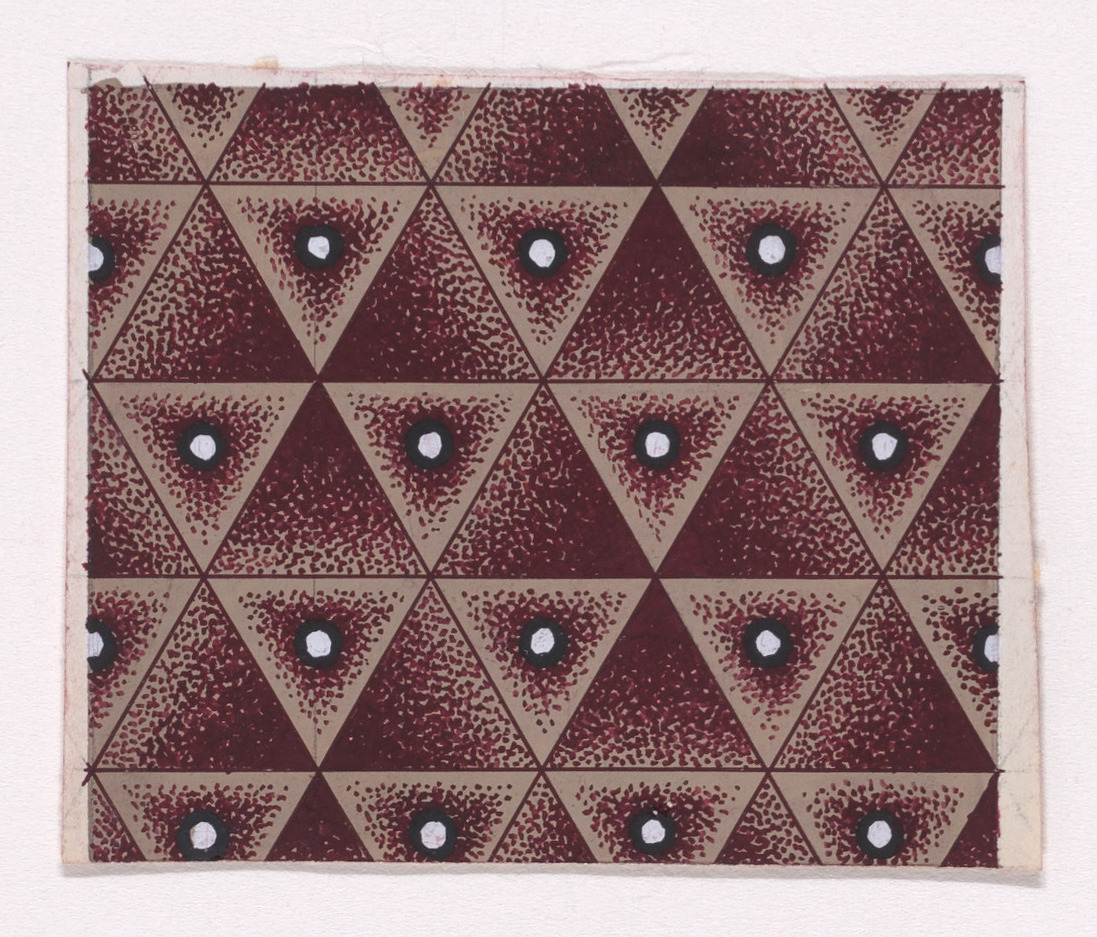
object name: drawing ornament architecture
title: Textile Design with a Seamless Pattern of Alternating Triangles Decorated with Pearls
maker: anonymous, alsatian, 19th century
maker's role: artist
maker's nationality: alsatian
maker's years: 1800-1900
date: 1840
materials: gouache